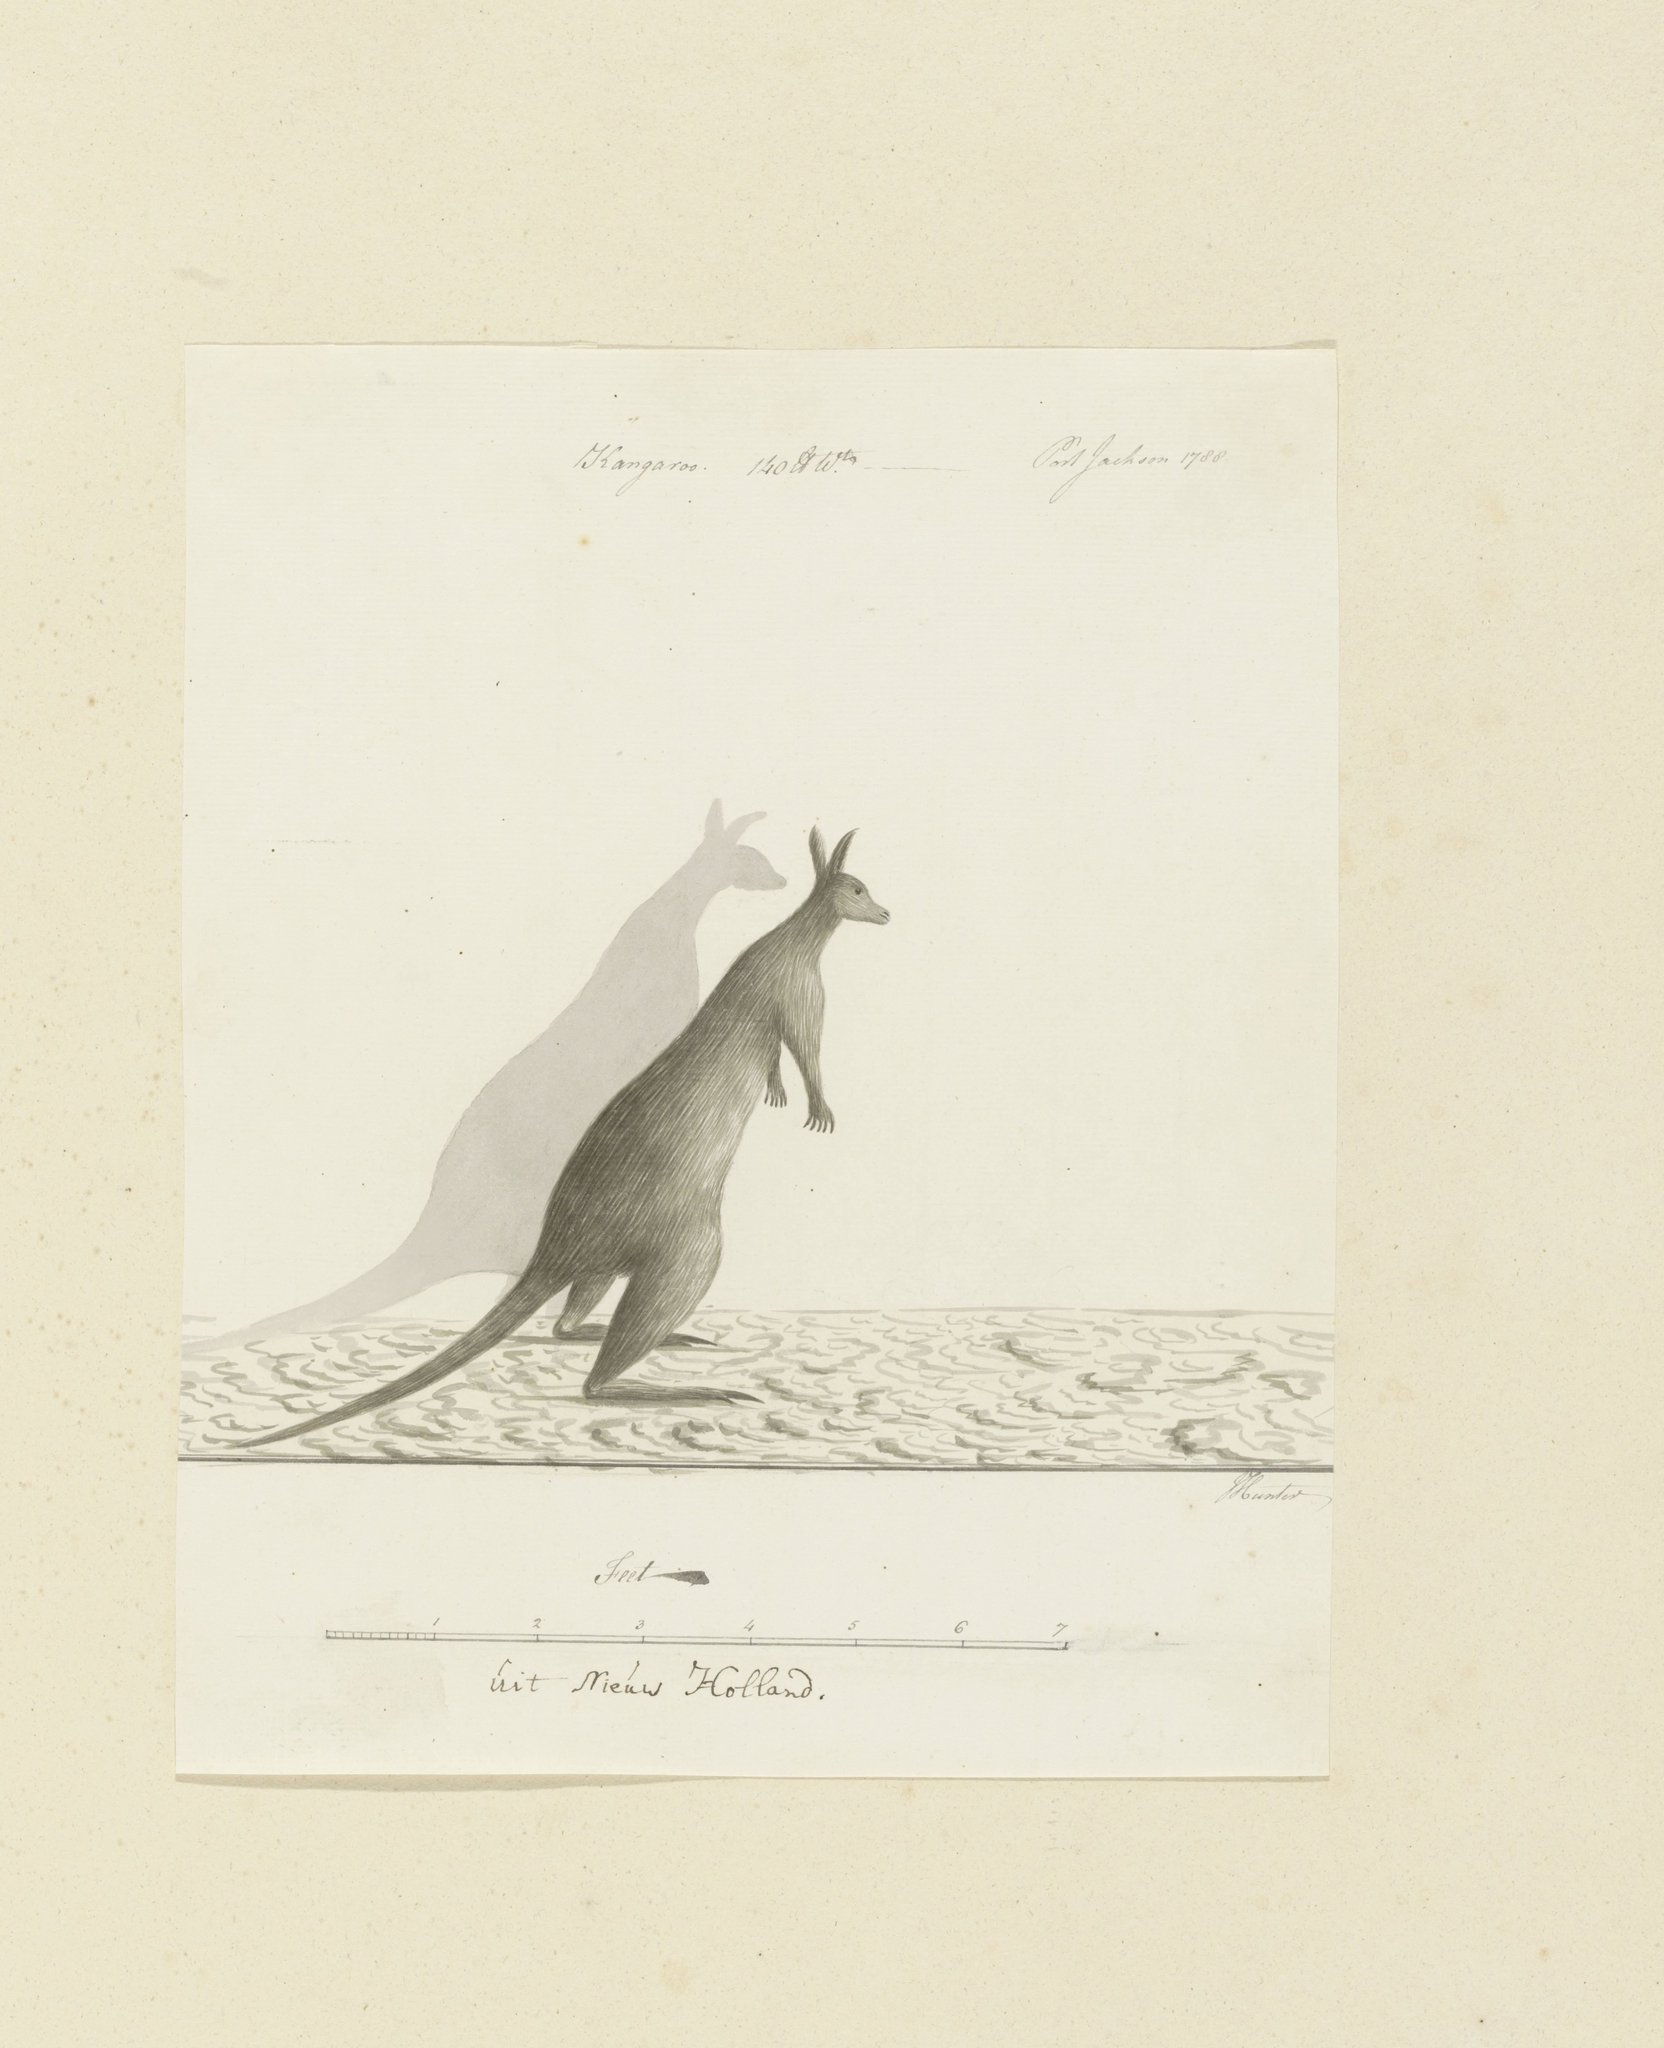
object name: drawing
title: Macropus sp. (Kangaroo)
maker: john hunter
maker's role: naval officer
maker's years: 1737-1821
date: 1788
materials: ink, paper, watercolor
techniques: brush, pen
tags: other mammals (with name)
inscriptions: annotation: ‘m.b.: Kangaroo, 140 Ct.Wt.; r.b.: Port Jackson + datum; m.o. : Feet (boven schaal) en: uit Nieuw Holland. (onder schaal)’, signature and date: ‘r.b. Port... 1788; rechts onder voorstelling: JHunter’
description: De kangoeroe komt niet voor in Zuid-Afrika. Admiraal Hunter was officier in de Engelse marine vanaf 1754 en reisde tussen okt. 1788 en mei 1789 naar de Kaap de Goede Hoop; een soortgelijke tekening van een kangoeroe van zijn hand berust in de National Library of Australia, Canberra (NK 2039).. Niet uit de Atlas Gordon, maar waarschijnlijk aan Gordon geschonken door de kunstenaar tijdens zijn verblijf in Kaapstad.